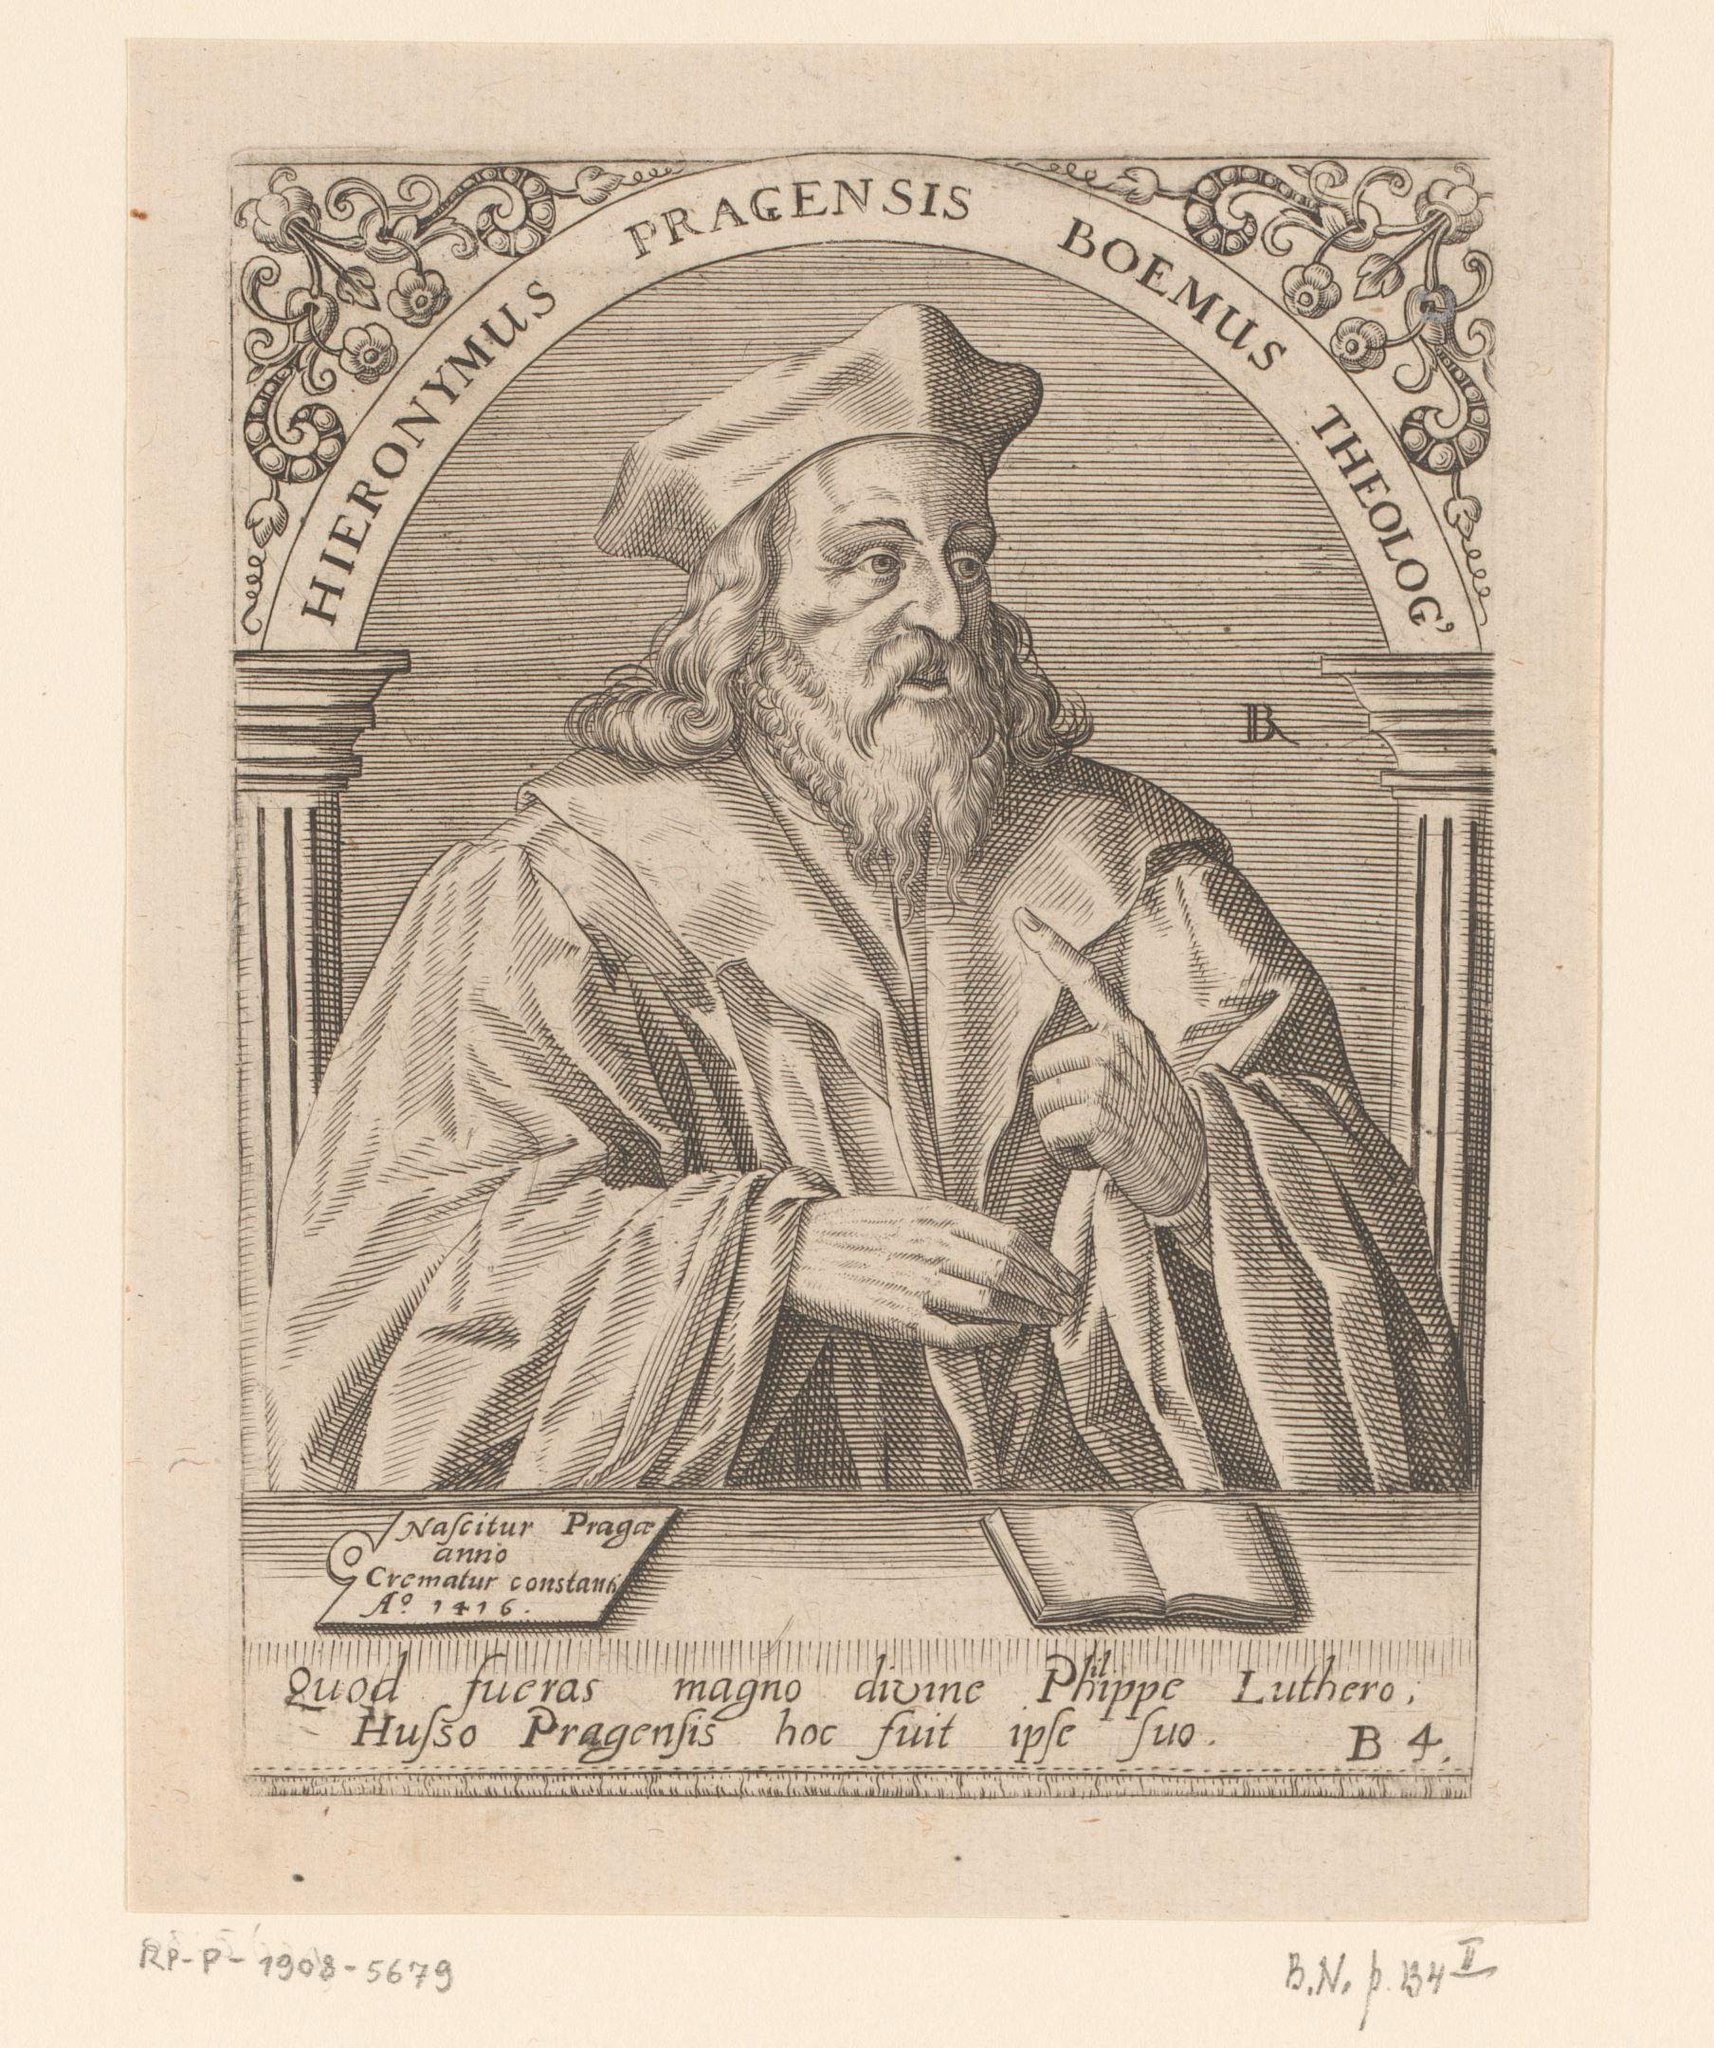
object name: print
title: Serie portretten van vijftiende- en zestiende-eeuwse geleerden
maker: robert boissard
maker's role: print maker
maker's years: 1570-1611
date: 1597-1599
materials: paper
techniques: engraving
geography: france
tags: prague, historical persons, book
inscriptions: collector's mark: Lugt 2228